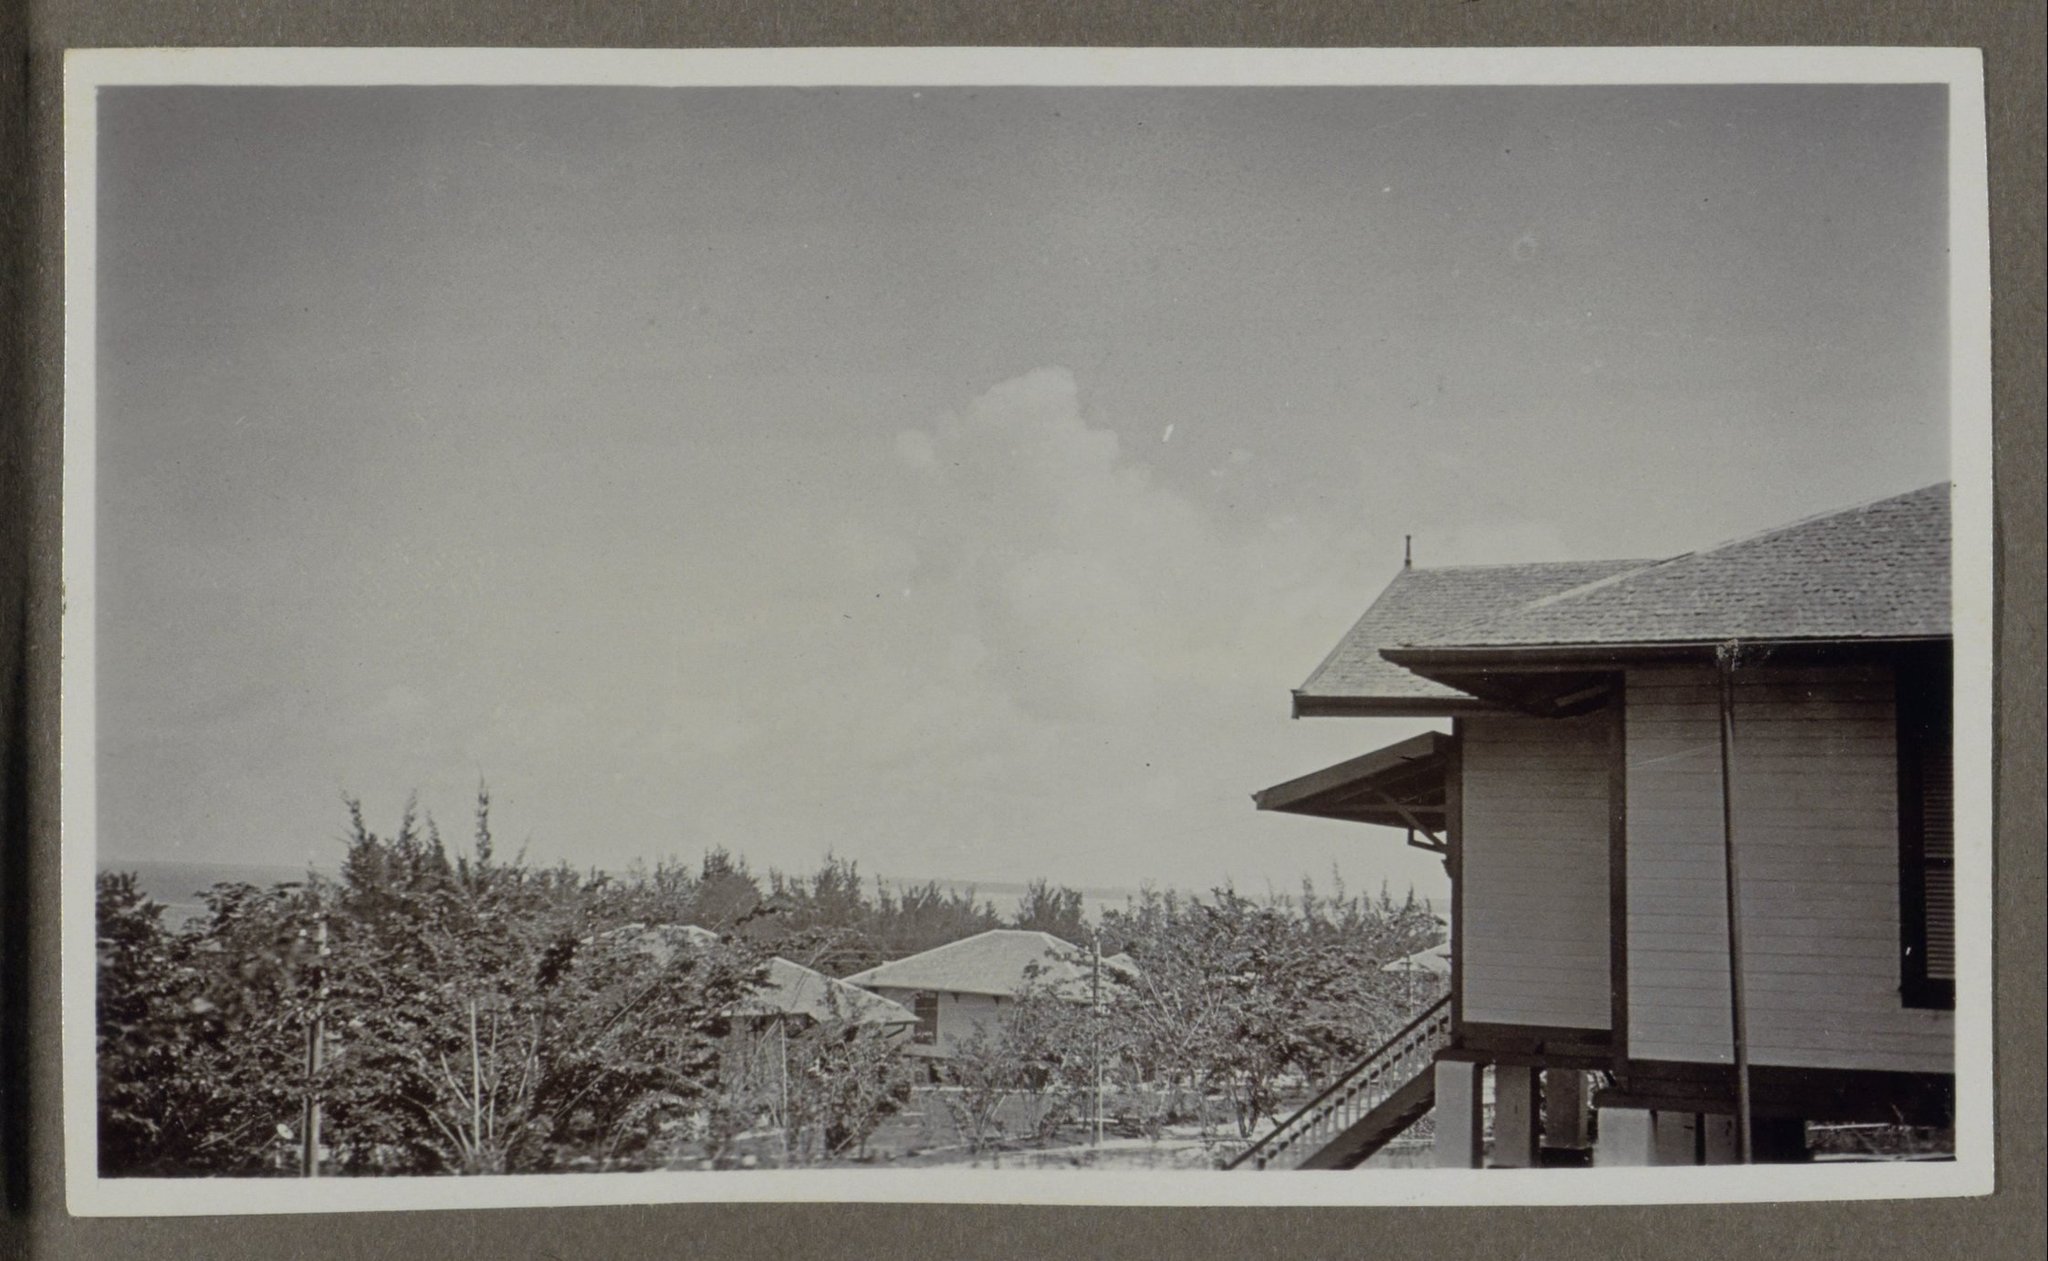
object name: photograph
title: Houten huis op palen en de begroeiing en bebouwing ervoor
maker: Anonymous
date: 1920-1930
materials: photographic support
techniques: gelatin silver print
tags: dutch east indies, the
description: Onderdeel van familiealbum Nederlands-Indië.